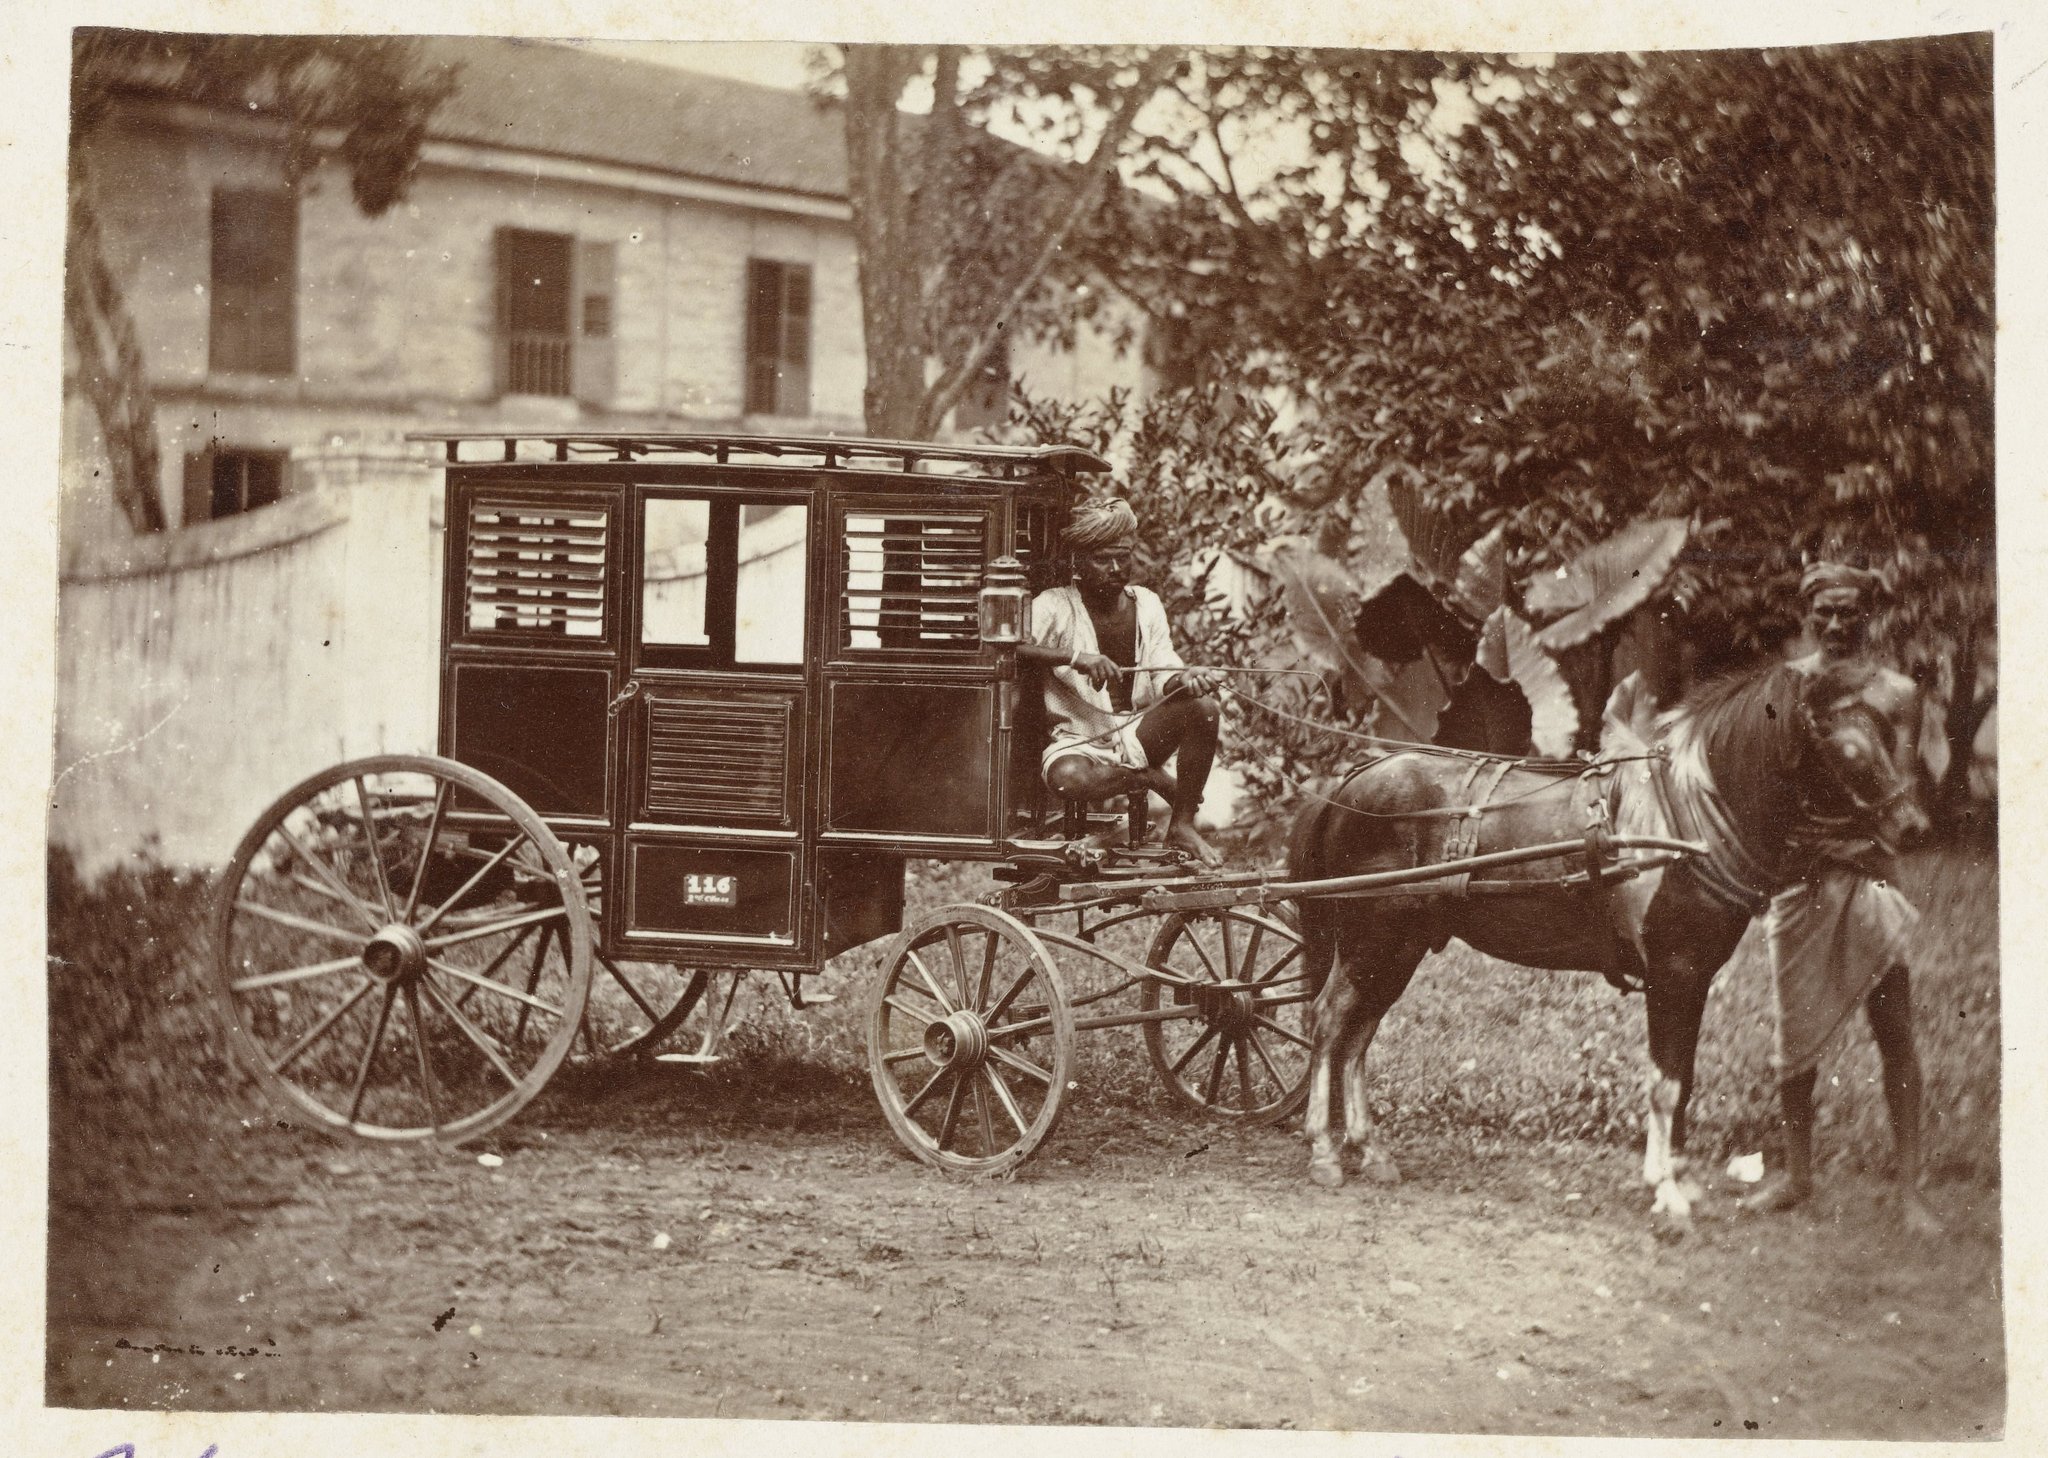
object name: photograph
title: Rijtuig met paard en lokale koetsier in Singapore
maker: Anonymous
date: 1890-1910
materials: cardboard, paper, photographic support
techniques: gelatin silver print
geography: singapore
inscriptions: caption: ‘Nackcarriage Singapore’